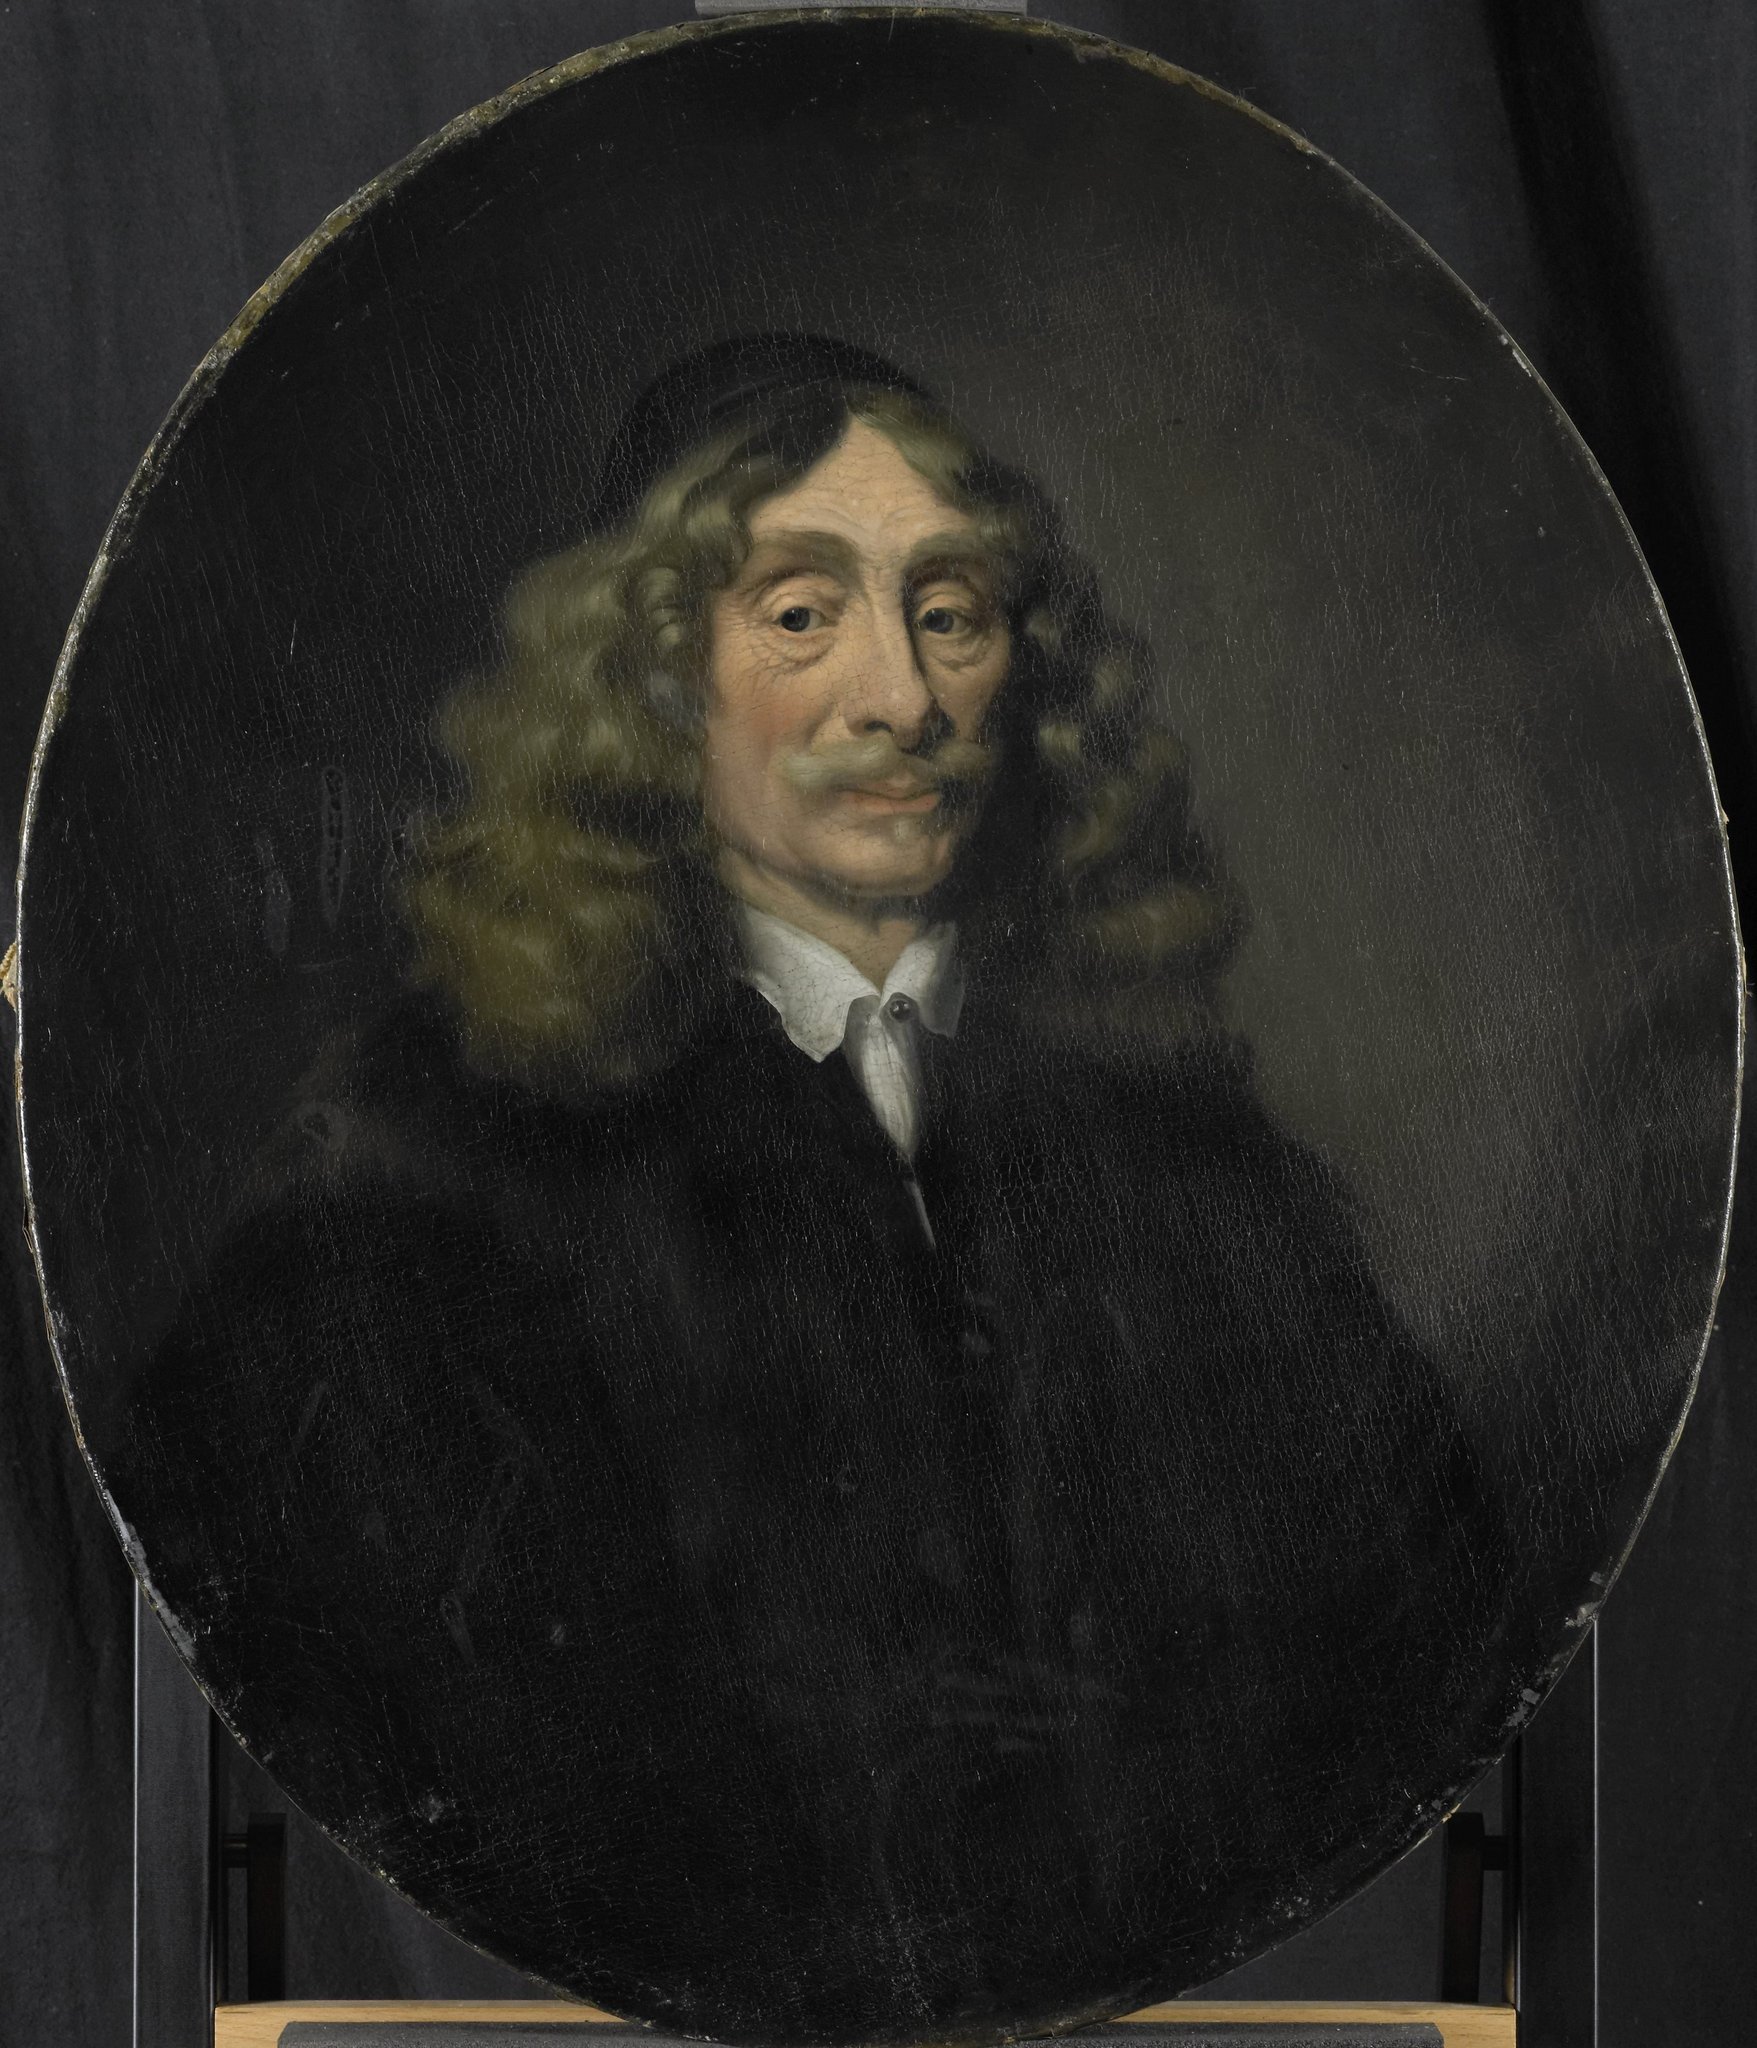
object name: painting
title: Portrait of Johan de Reus, Director of the Rotterdam Chamber of the Dutch East India Company, elected 1657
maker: pieter van der werff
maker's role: draughtsman, painter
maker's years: 1665-1722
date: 1695-1722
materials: canvas, oil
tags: rotterdam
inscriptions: inscription: ‘Johans de Reus’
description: Portret van Johan Abrahamsz. de Reus (ca. 1598-1685), gekozen in 1657. Buste in ovaal naar rechts. Kopie naar het portret van Nicolaes Maes in de National Gallery te Londen. Onderdeel van een reeks portretten van de bewindhebbers van de Rotterdamse Kamer van de Verenigde Oost-Indische Compagnie, vervaardigd voor het Nieuw Oost-Indisch Huis uit 1698 aan de Boompjes te Rotterdam.